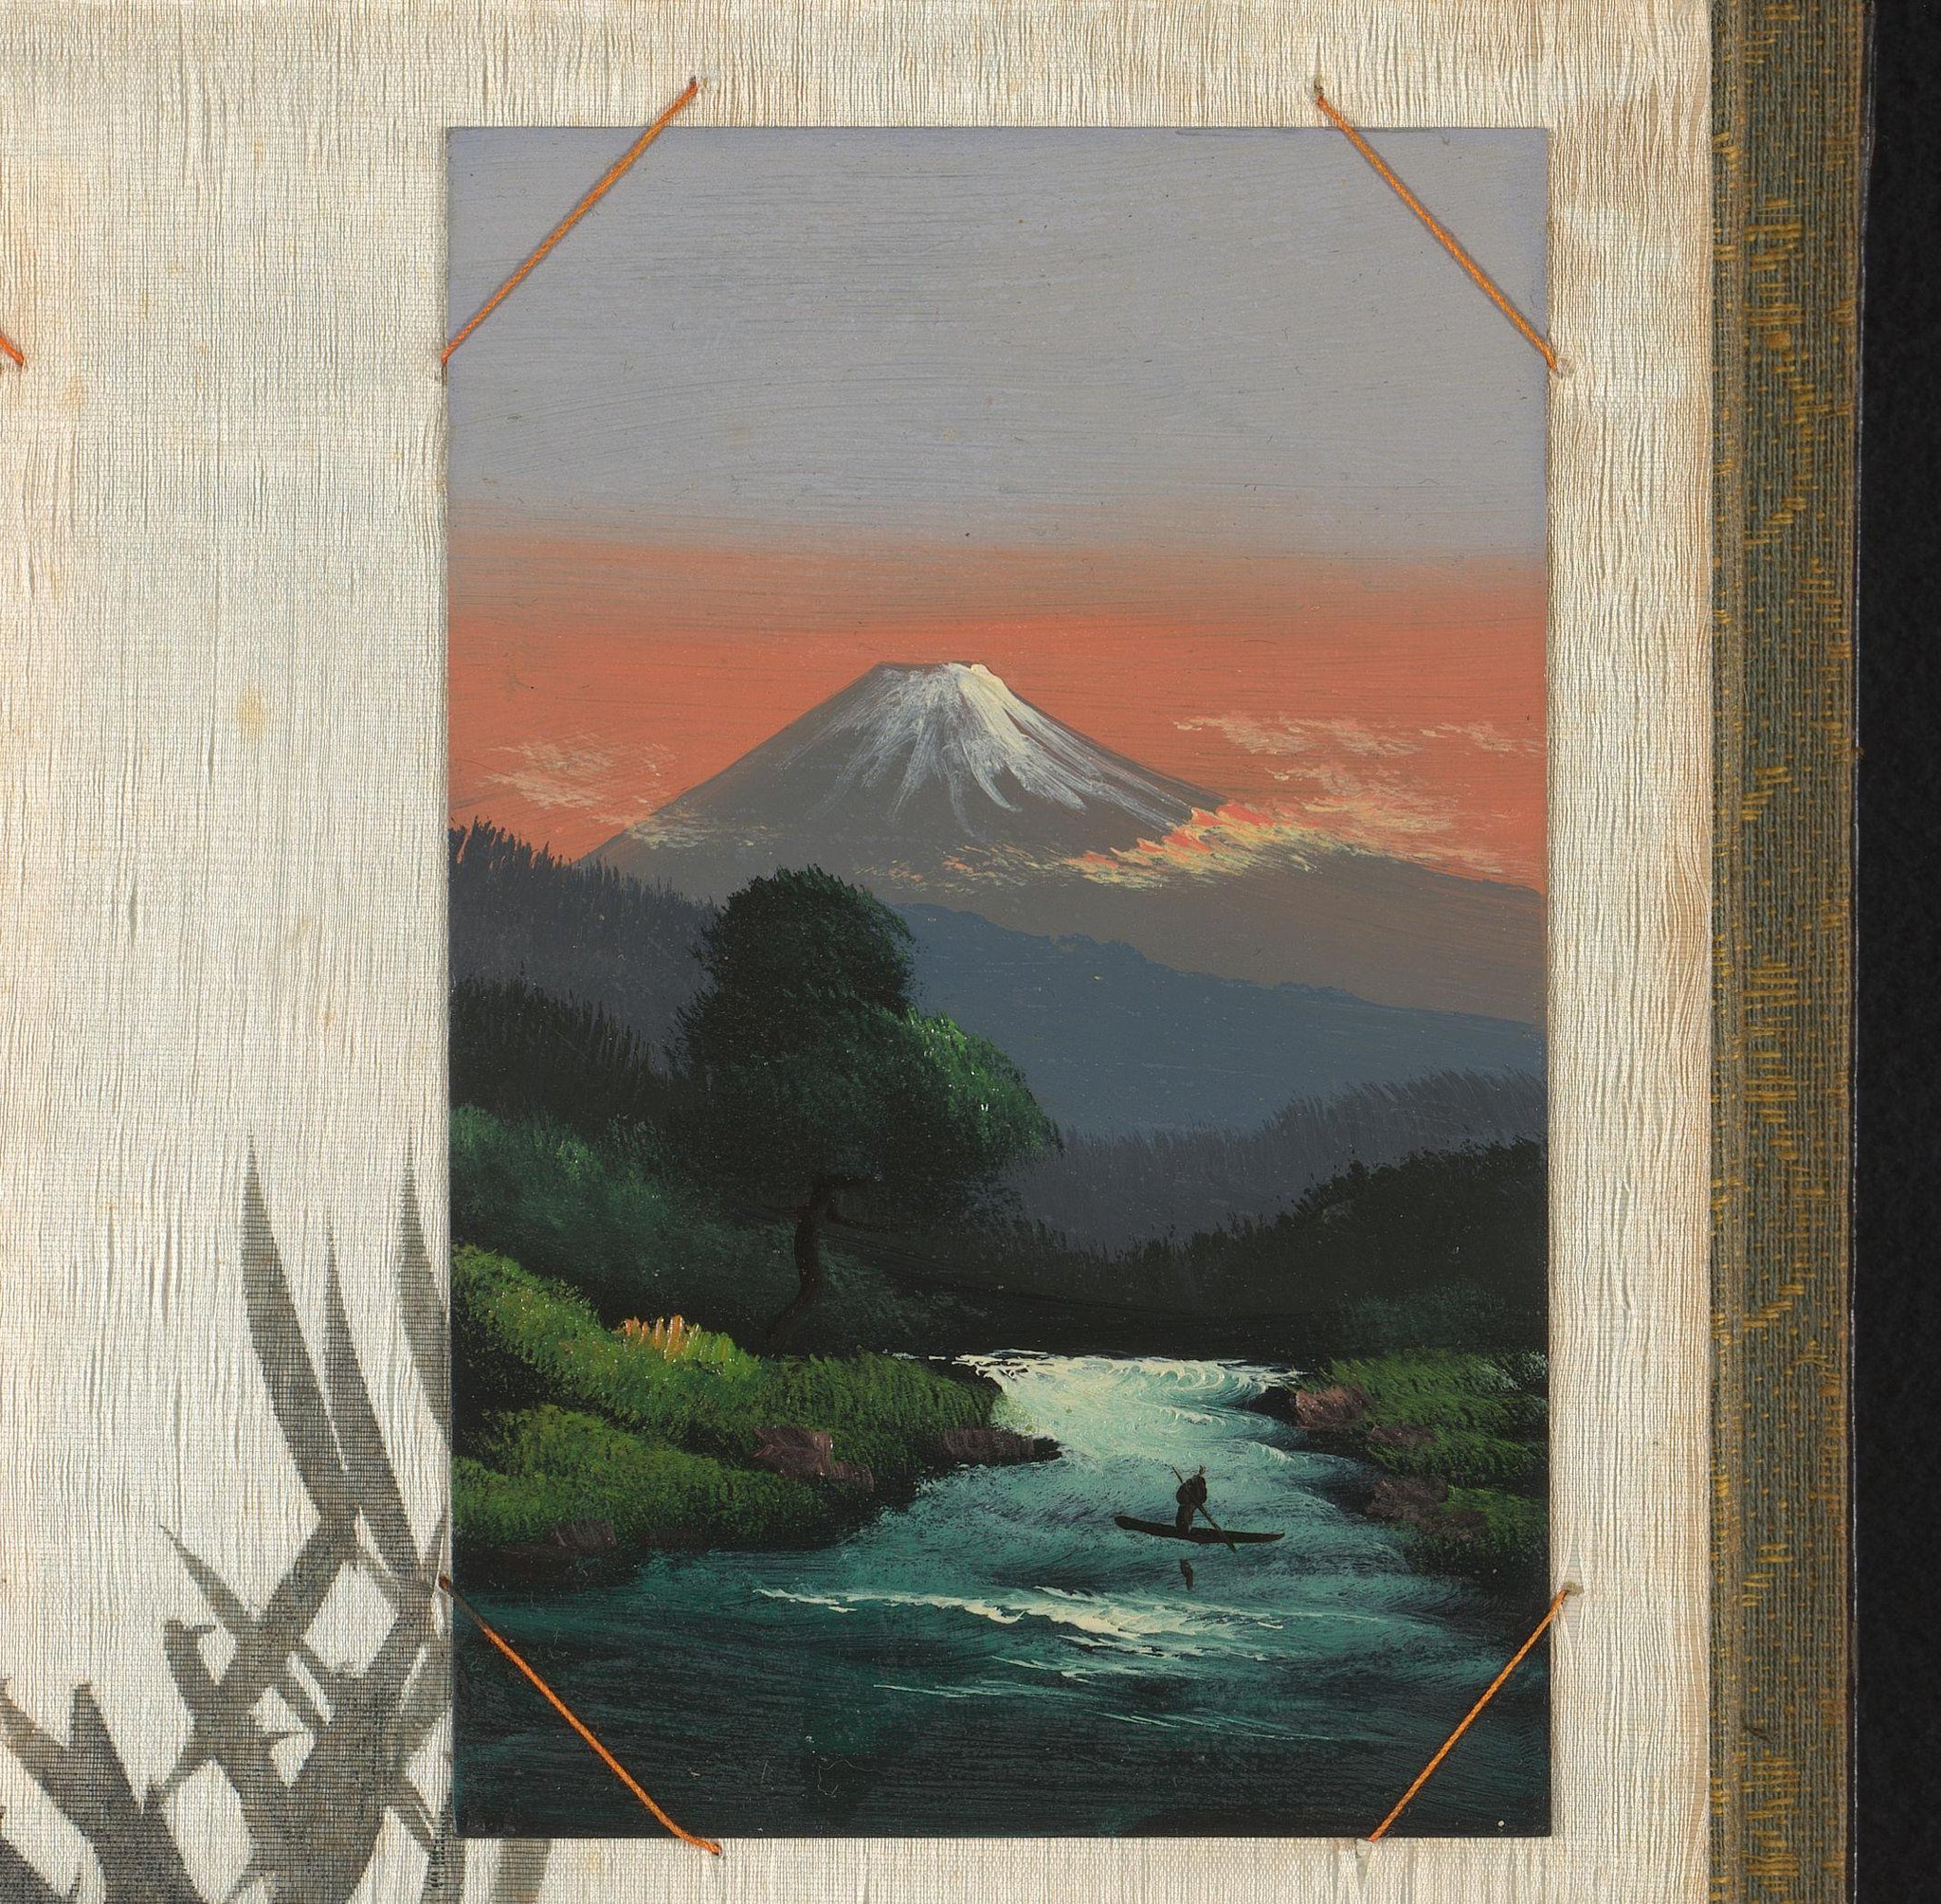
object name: drawing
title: Gezicht op een landschap met rivier waarop een traditionele vissersboot, vermoedelijk in Japan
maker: Anonymous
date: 1870-1900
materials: cardboard, paint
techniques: brush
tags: river, mountain-top, peak, poling, punting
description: Deze tekening maakt deel uit van een album.